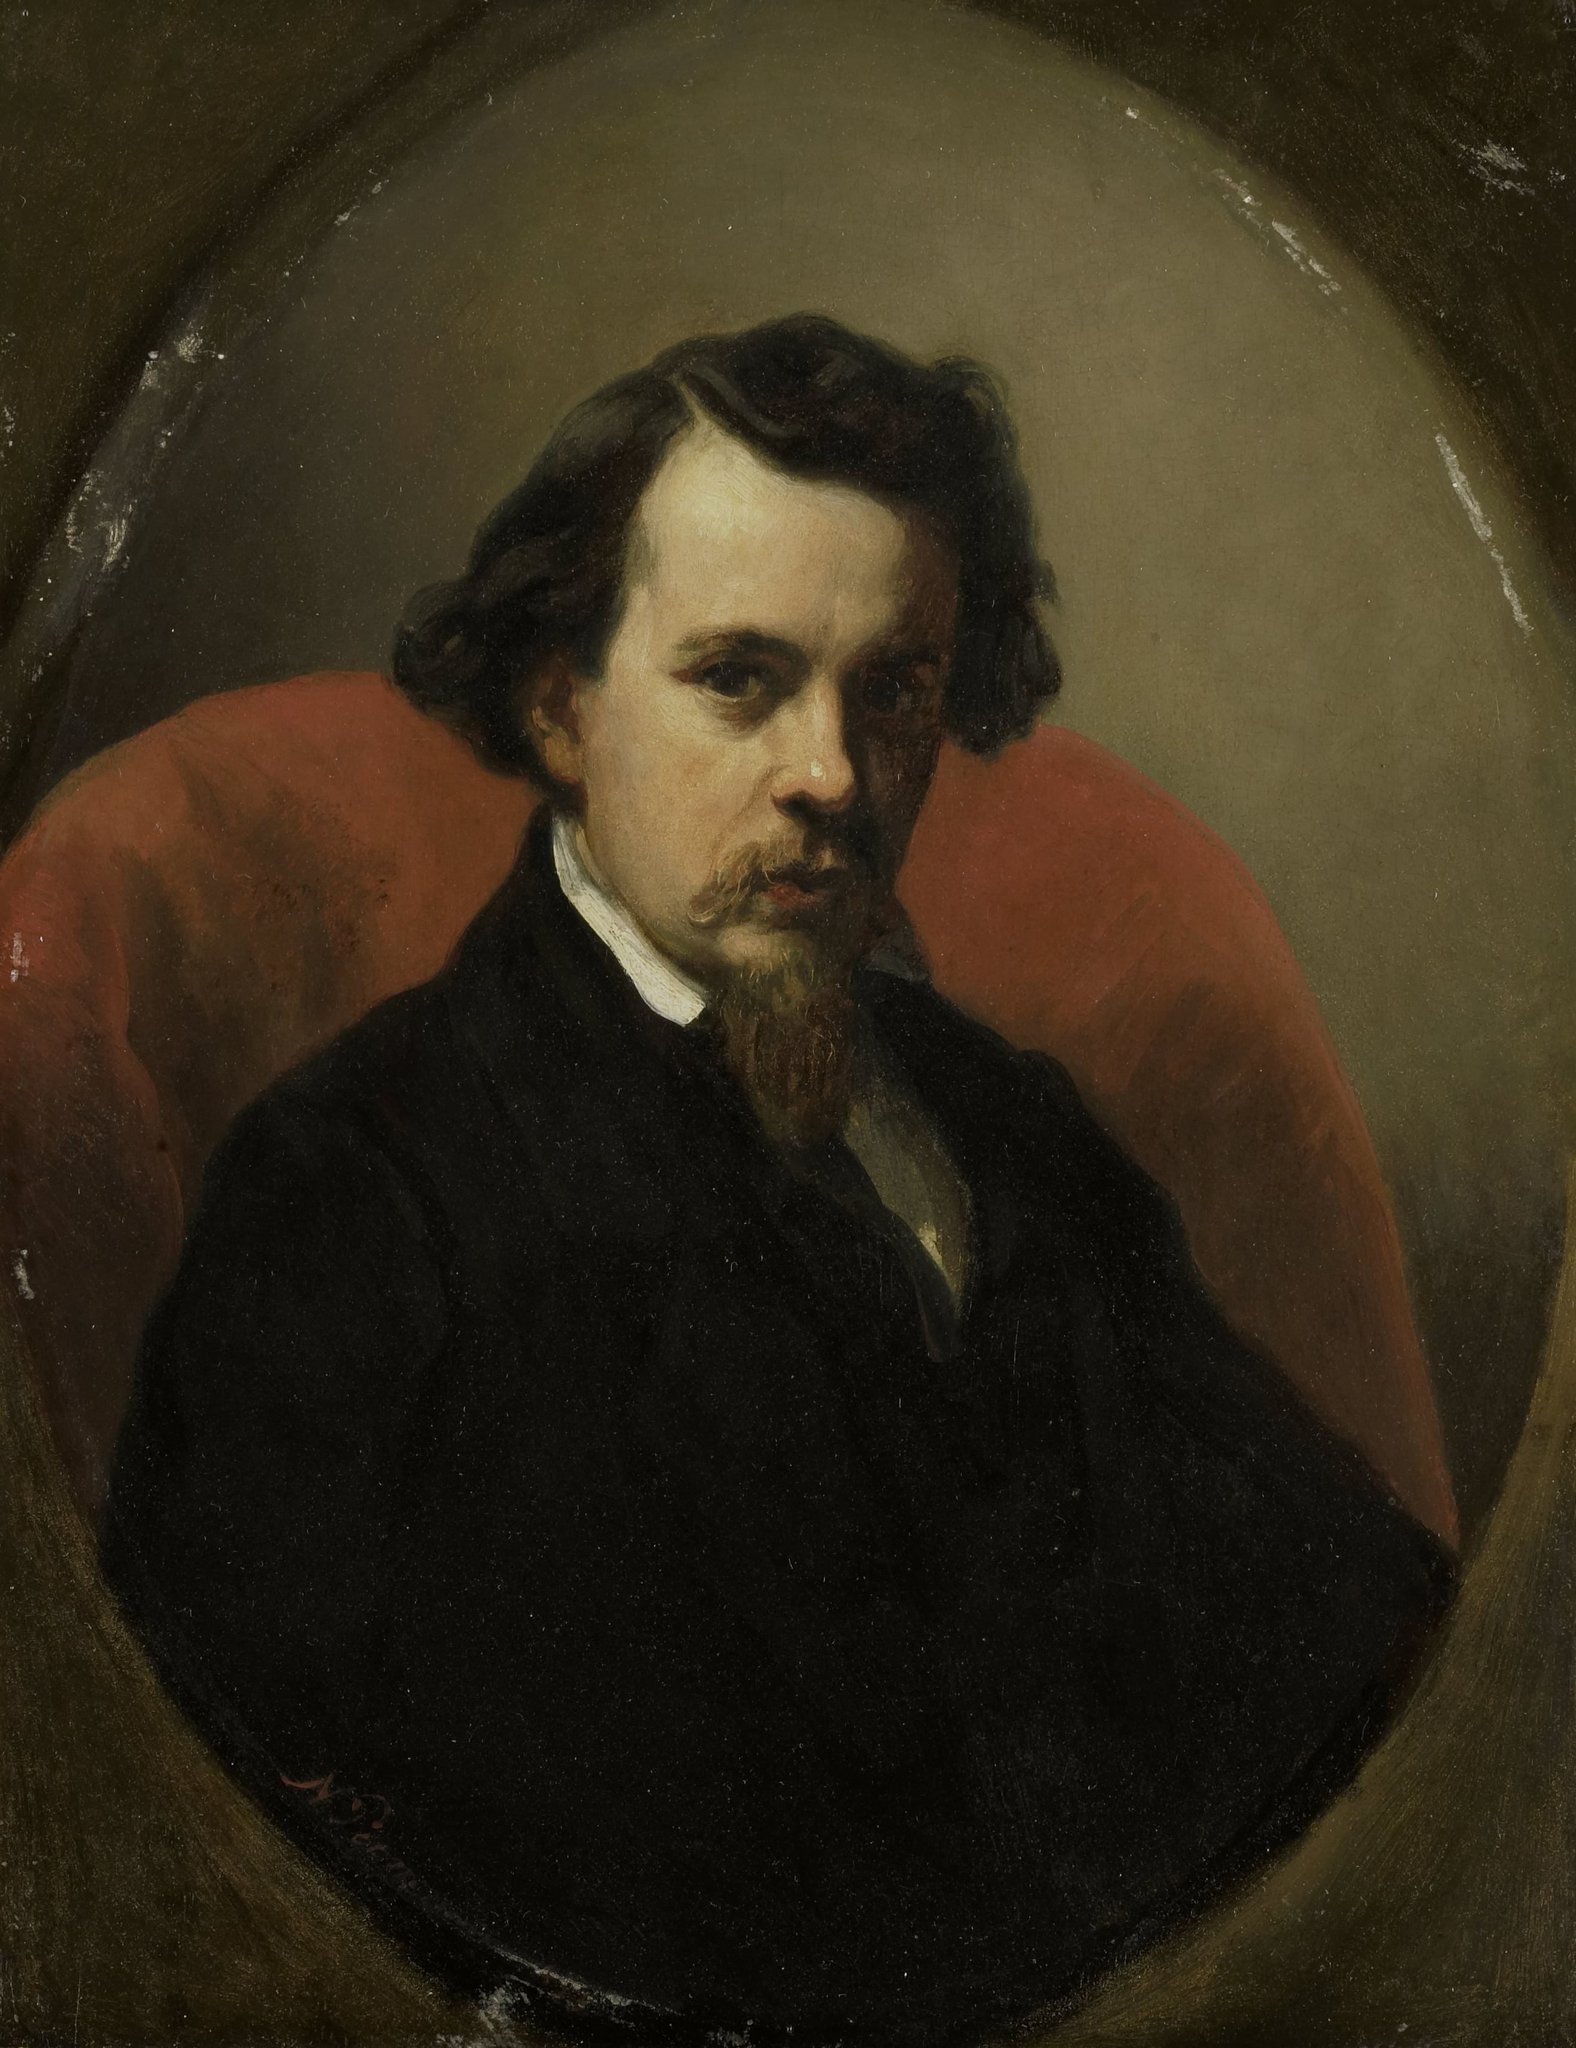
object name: painting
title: Portrait of Charles Henri Joseph Leicker, Painter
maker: nicolaas pieneman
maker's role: draughtsman, painter, print maker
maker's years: 1809-1860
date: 1853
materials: oil, panel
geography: netherlands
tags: brussels, painter, print maker, draughtsman, charles leickert, portrait, self-portrait of painter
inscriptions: signature and date: ‘N. Pieneman 1853’, inscription: ‘Portret van Ch. H. Leickert geschilderd door N. Pieneman. 1853’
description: Portret van de schilder Charles Henri Joseph Leickert (1816-1907). Buste, in een ovale lijst, zittend in een stoel.